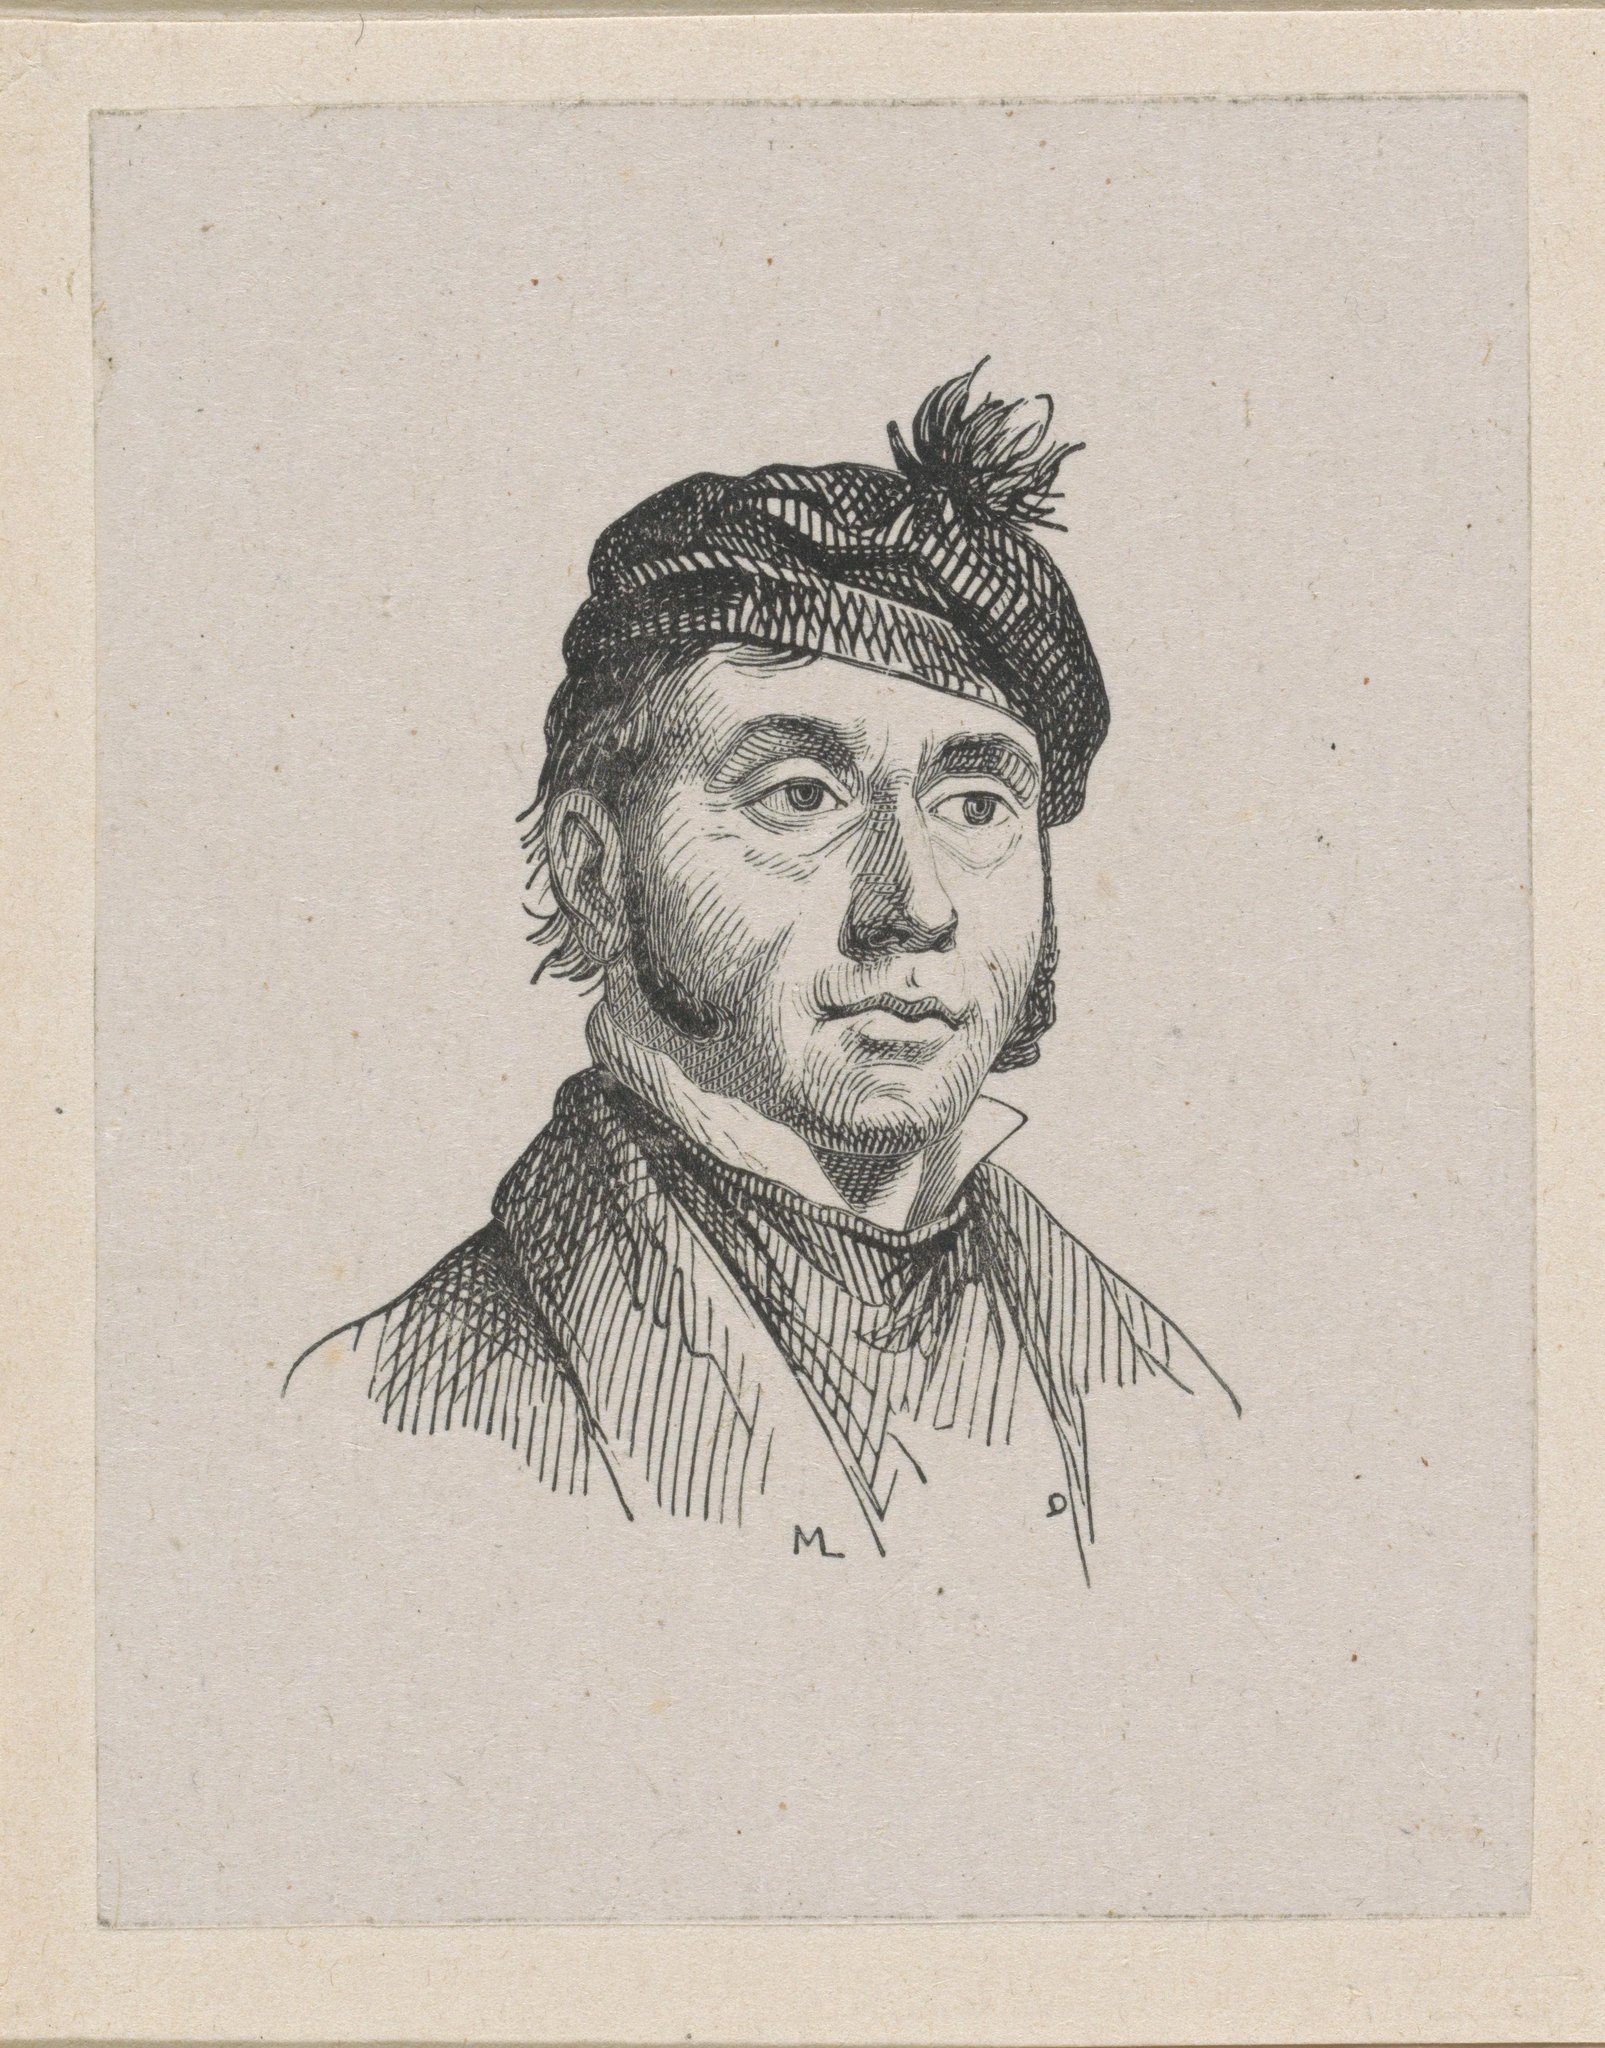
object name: print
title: Portret van Pierre François de Noter (de Jonge)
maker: monogrammist ml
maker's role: print maker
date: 1800-1900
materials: paper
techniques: engraving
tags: ghent, painter, print maker, pierre françois de noter, historical persons, portrait, self-portrait of artist